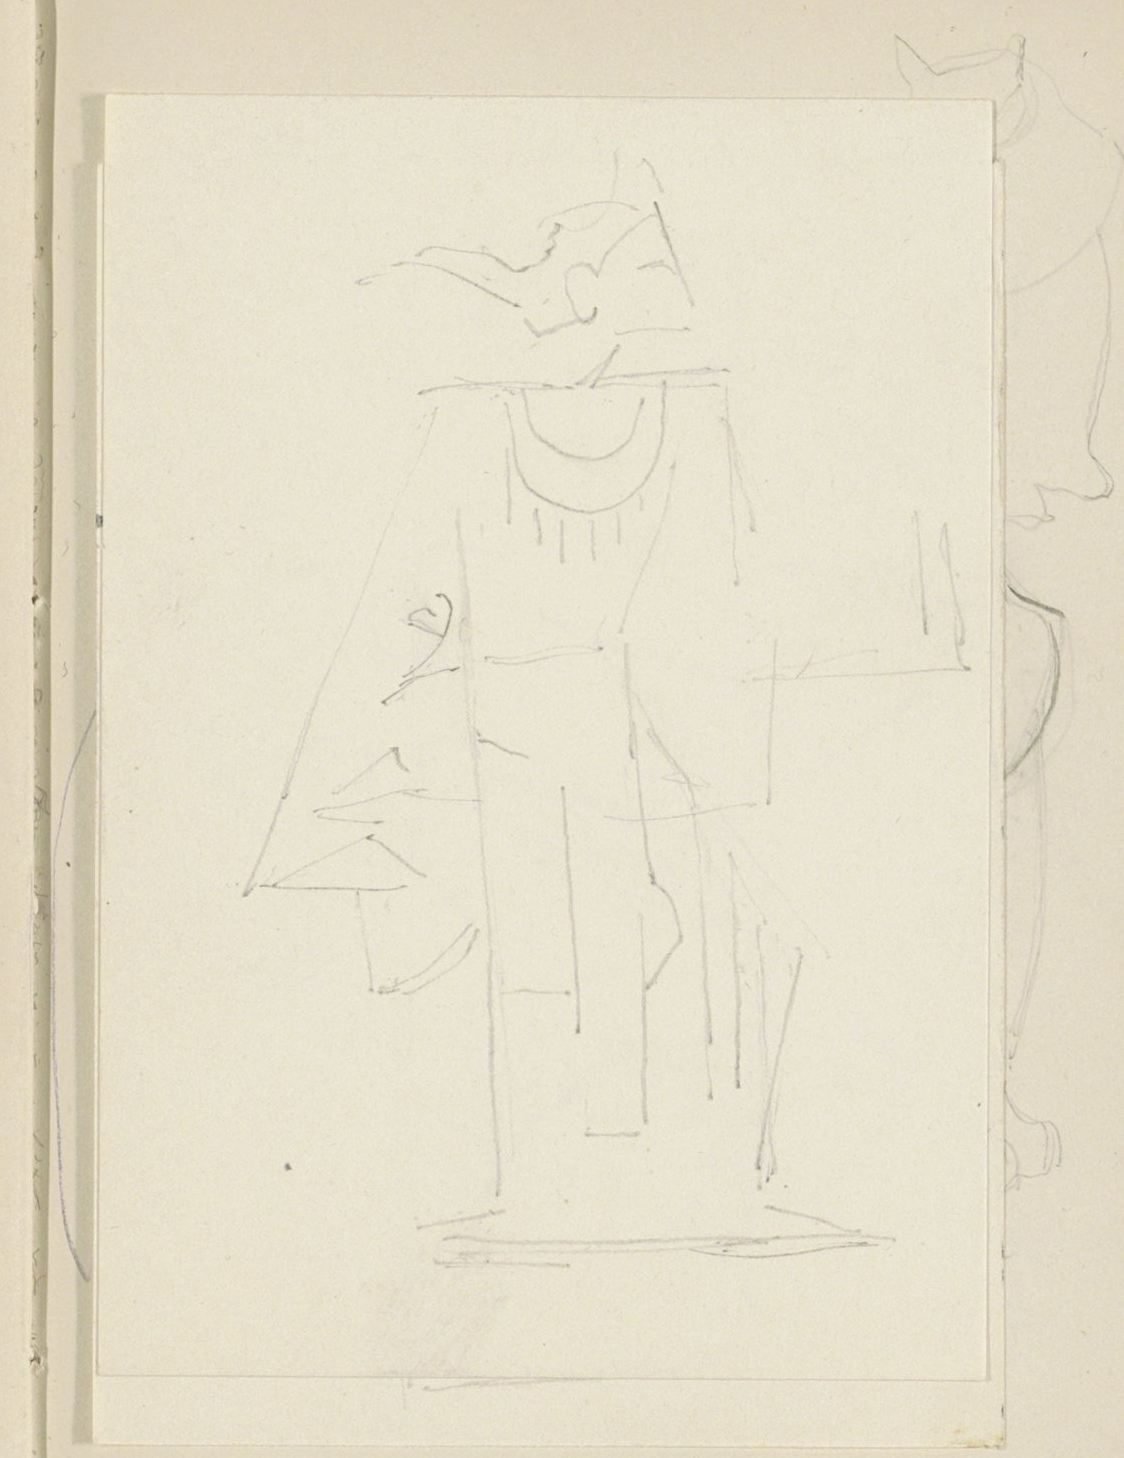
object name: sketchbook leaf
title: Staande figuur in Egyptisch kostuum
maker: reijer stolk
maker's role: draughtsman, print maker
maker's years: 1896-1945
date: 1906-1945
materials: paper, pencil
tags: egyptian hieroglyphs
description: Vermoedelijk getekend naar een (voorbeeld van) een hiëroglief. Losse tekening tussen blad 41 verso en 42 recto uit een schetsboek met 69 bladen.